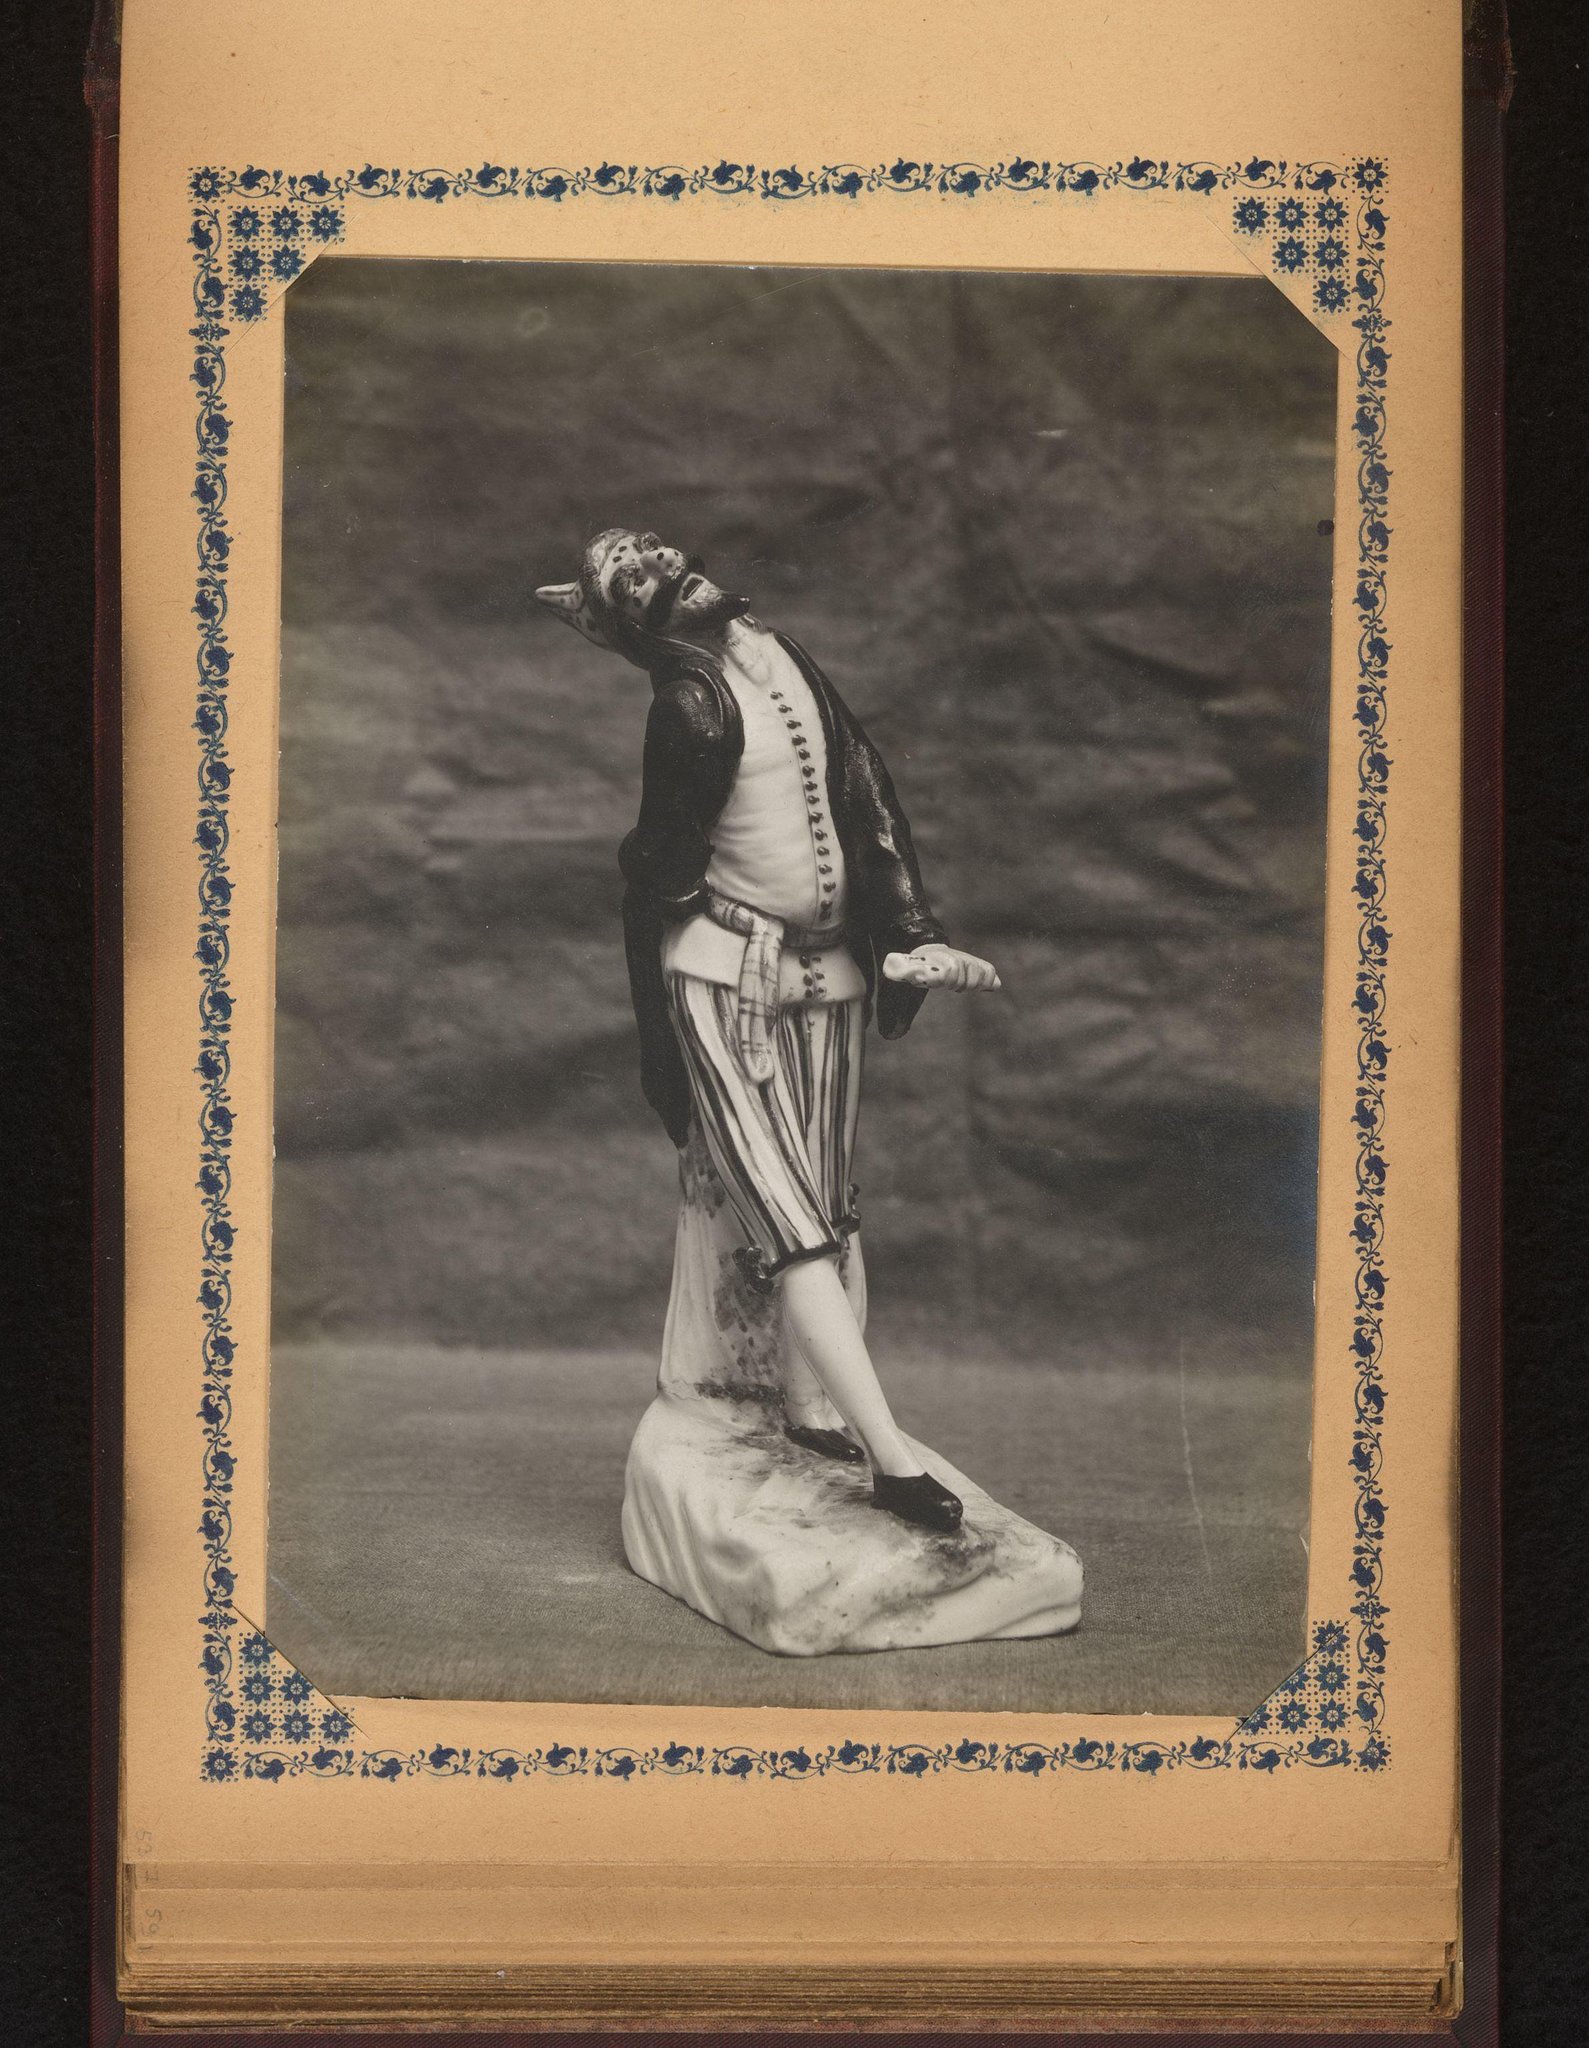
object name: photograph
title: Sculptuur van een figuur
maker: Anonymous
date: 1880-1940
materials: cardboard, photographic support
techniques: gelatin silver print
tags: the (nude) human figure; 'corpo humano' (ripa), piece of sculpture, reproduction of a piece of sculpture